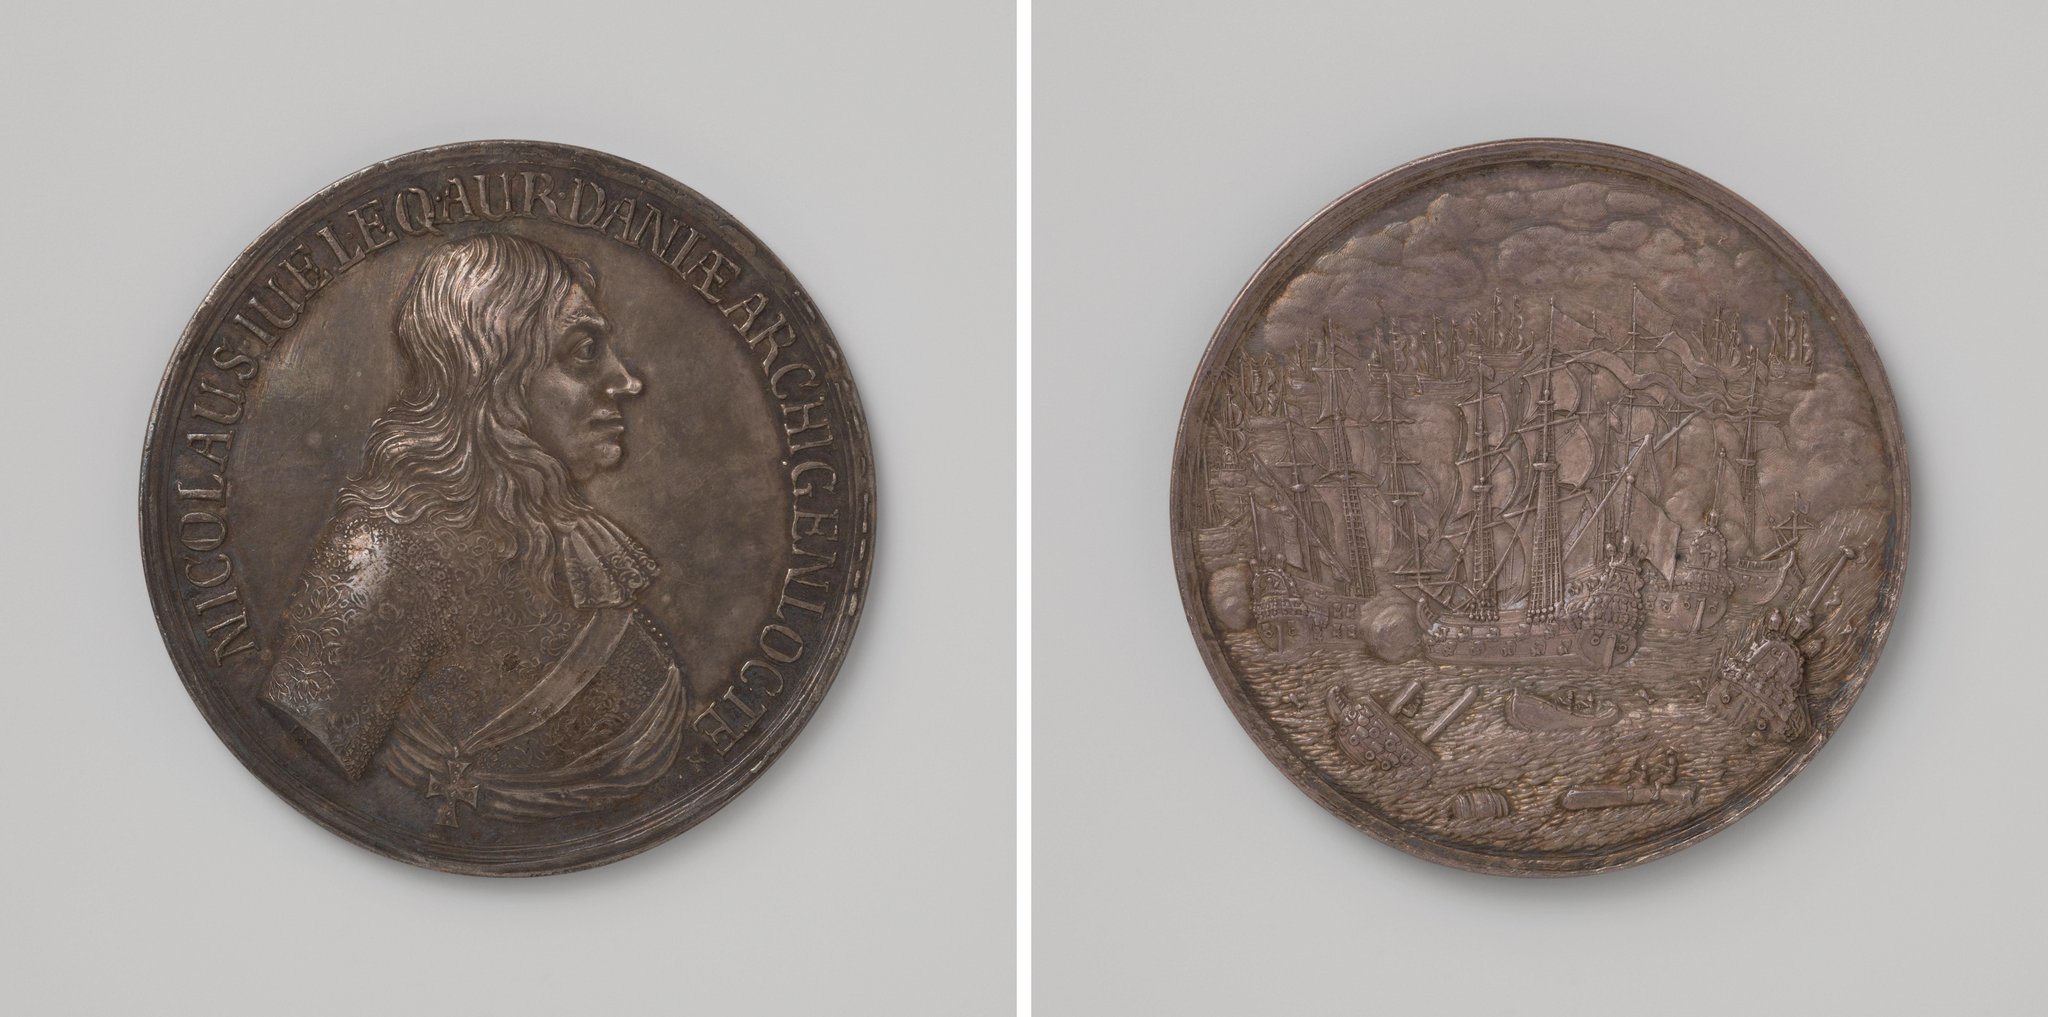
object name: history medal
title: Overwinningen op de Zweden, ter ere van admiraal Niels Juel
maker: johann höhn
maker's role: medailleur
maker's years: 1637-1693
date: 1677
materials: silver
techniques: striking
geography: danzig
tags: oslo, vlootvoogd, opperbevelhebber, niels juel, faeröer, zweden, langeland, öland, køge bugt, noordse oorlogen, schonense oorlog, slag bij langeland, slag bij öland, slag in de kooge bocht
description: Zilveren penning. Voorzijde: borststuk man binnen omschrift. Keerzijde: zeeslag.